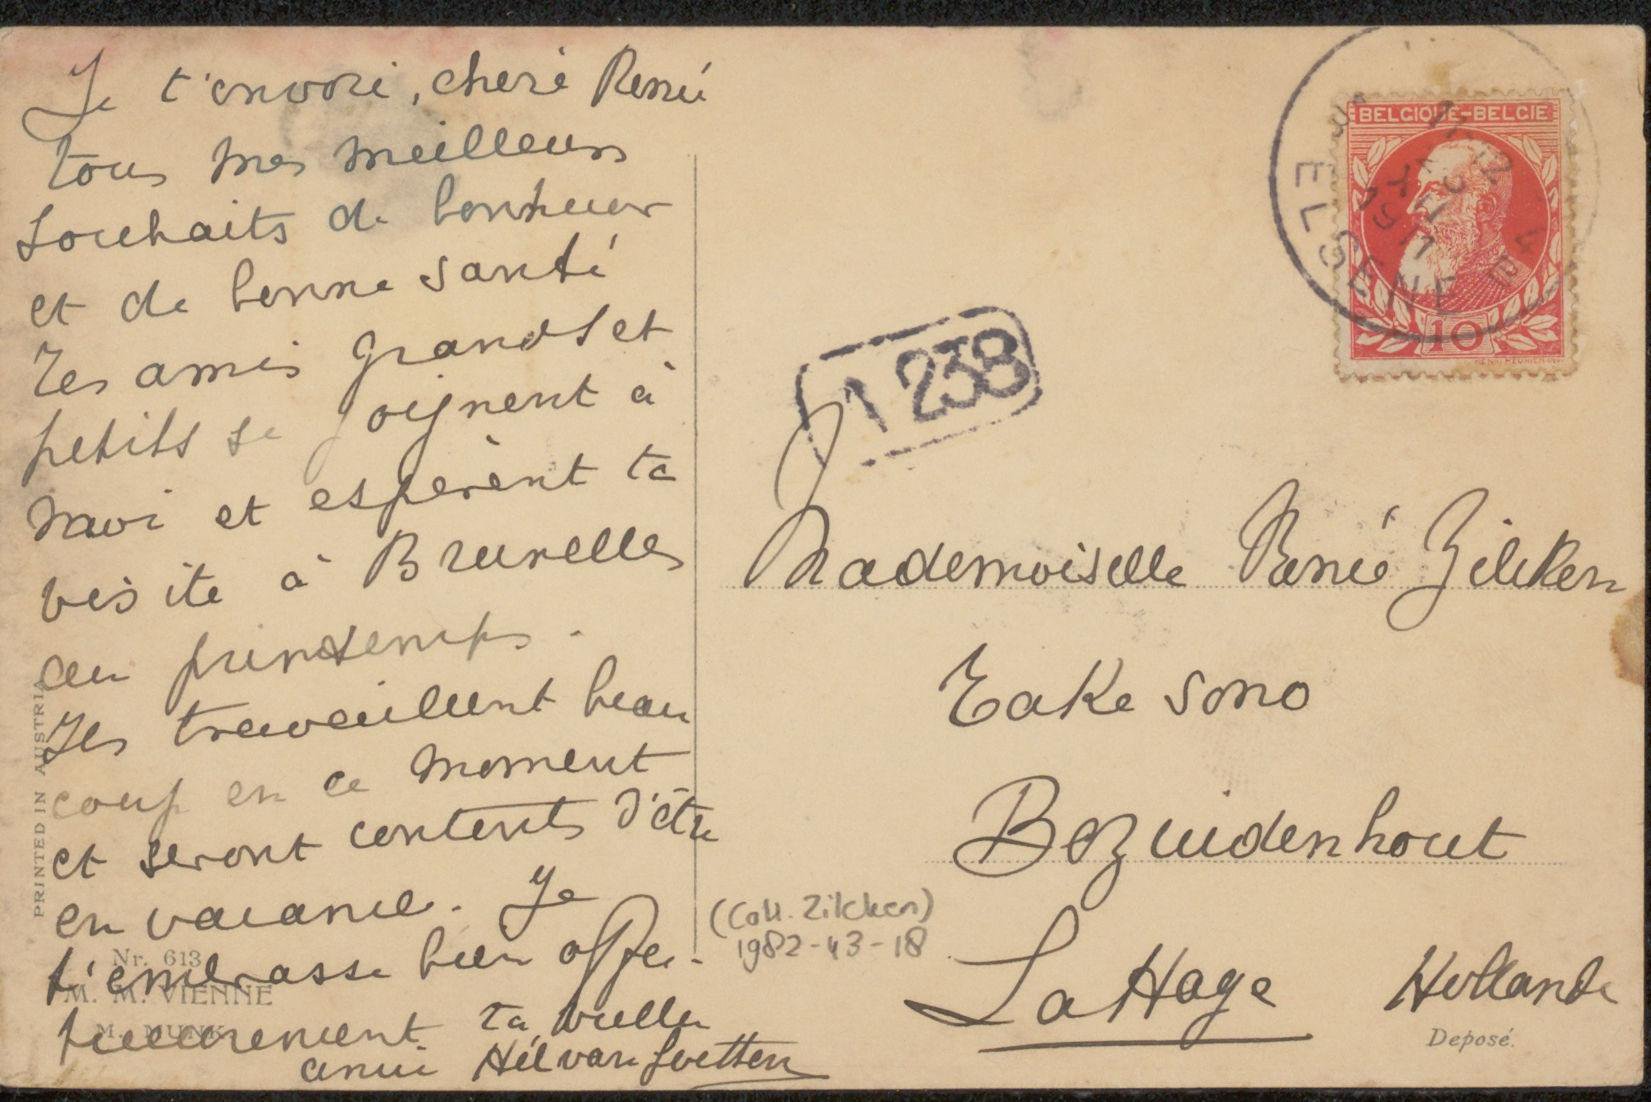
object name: ansichtkaart, prentbriefkaart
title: Prentbriefkaart aan Renée Hélène Laure Zilcken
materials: cardboard, ink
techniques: pen, printing, writing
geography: vienna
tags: voorburg, print maker, renée hélène laure zilcken, brussels